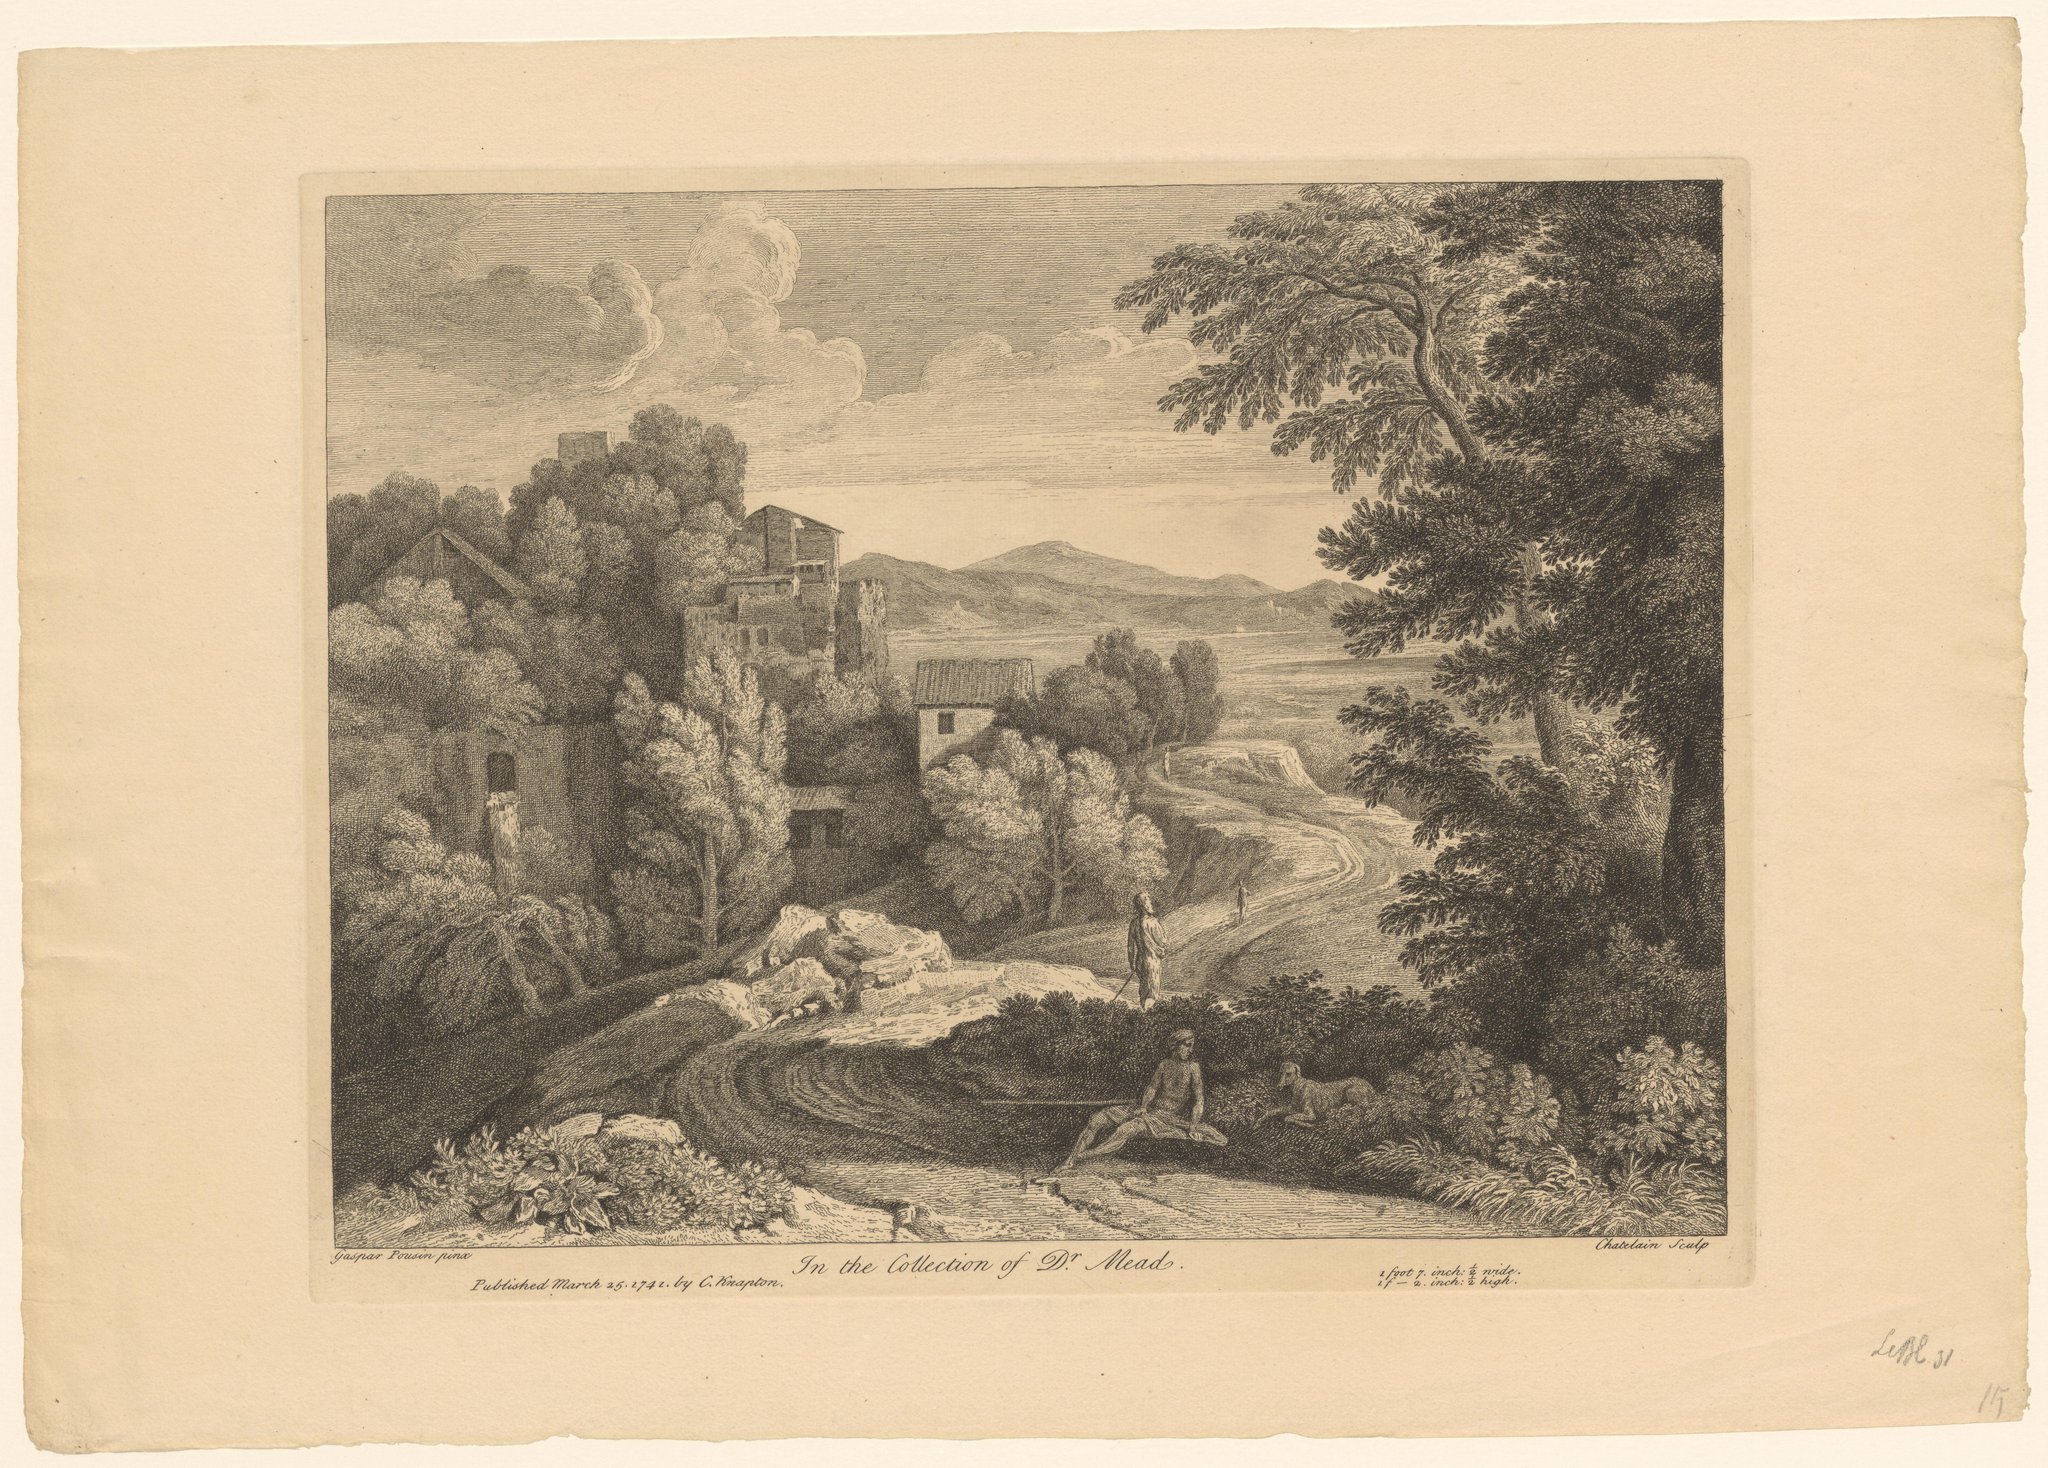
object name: print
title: Heuvellandschap met rustende wandelaar en een hond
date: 1741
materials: paper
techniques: etching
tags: (traveller) resting in the open air, low hill country (+ landscape with figures, staffage), pastorals, arcadian scenes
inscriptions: collector's mark: Lugt 2228